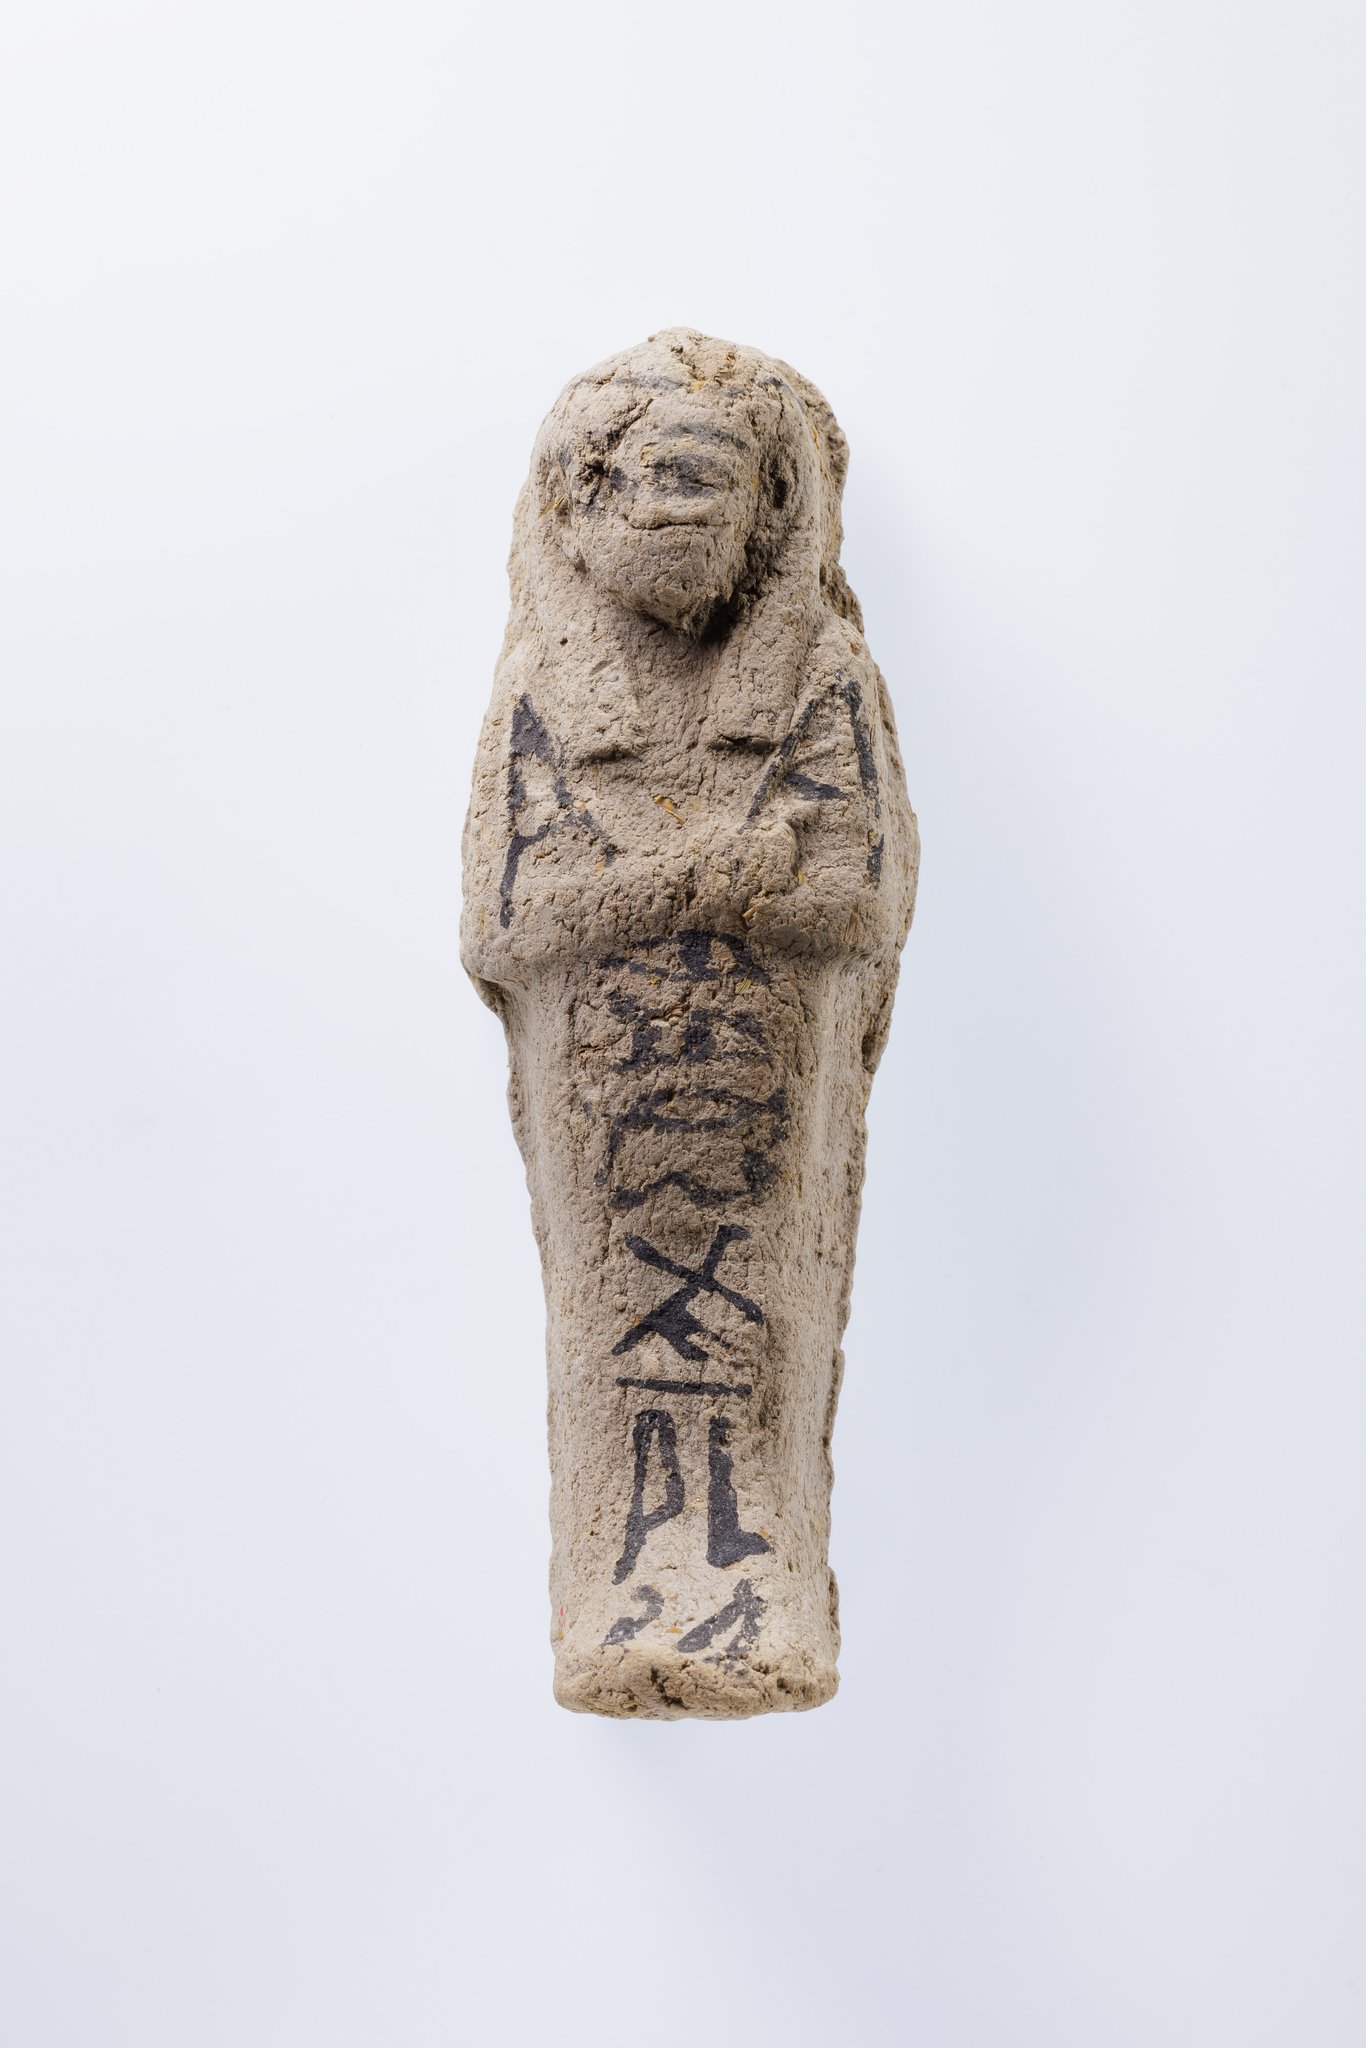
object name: shabti, mehefpabenu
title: Shabti of Mehefpabenu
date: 1070-945 BCE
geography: egypt